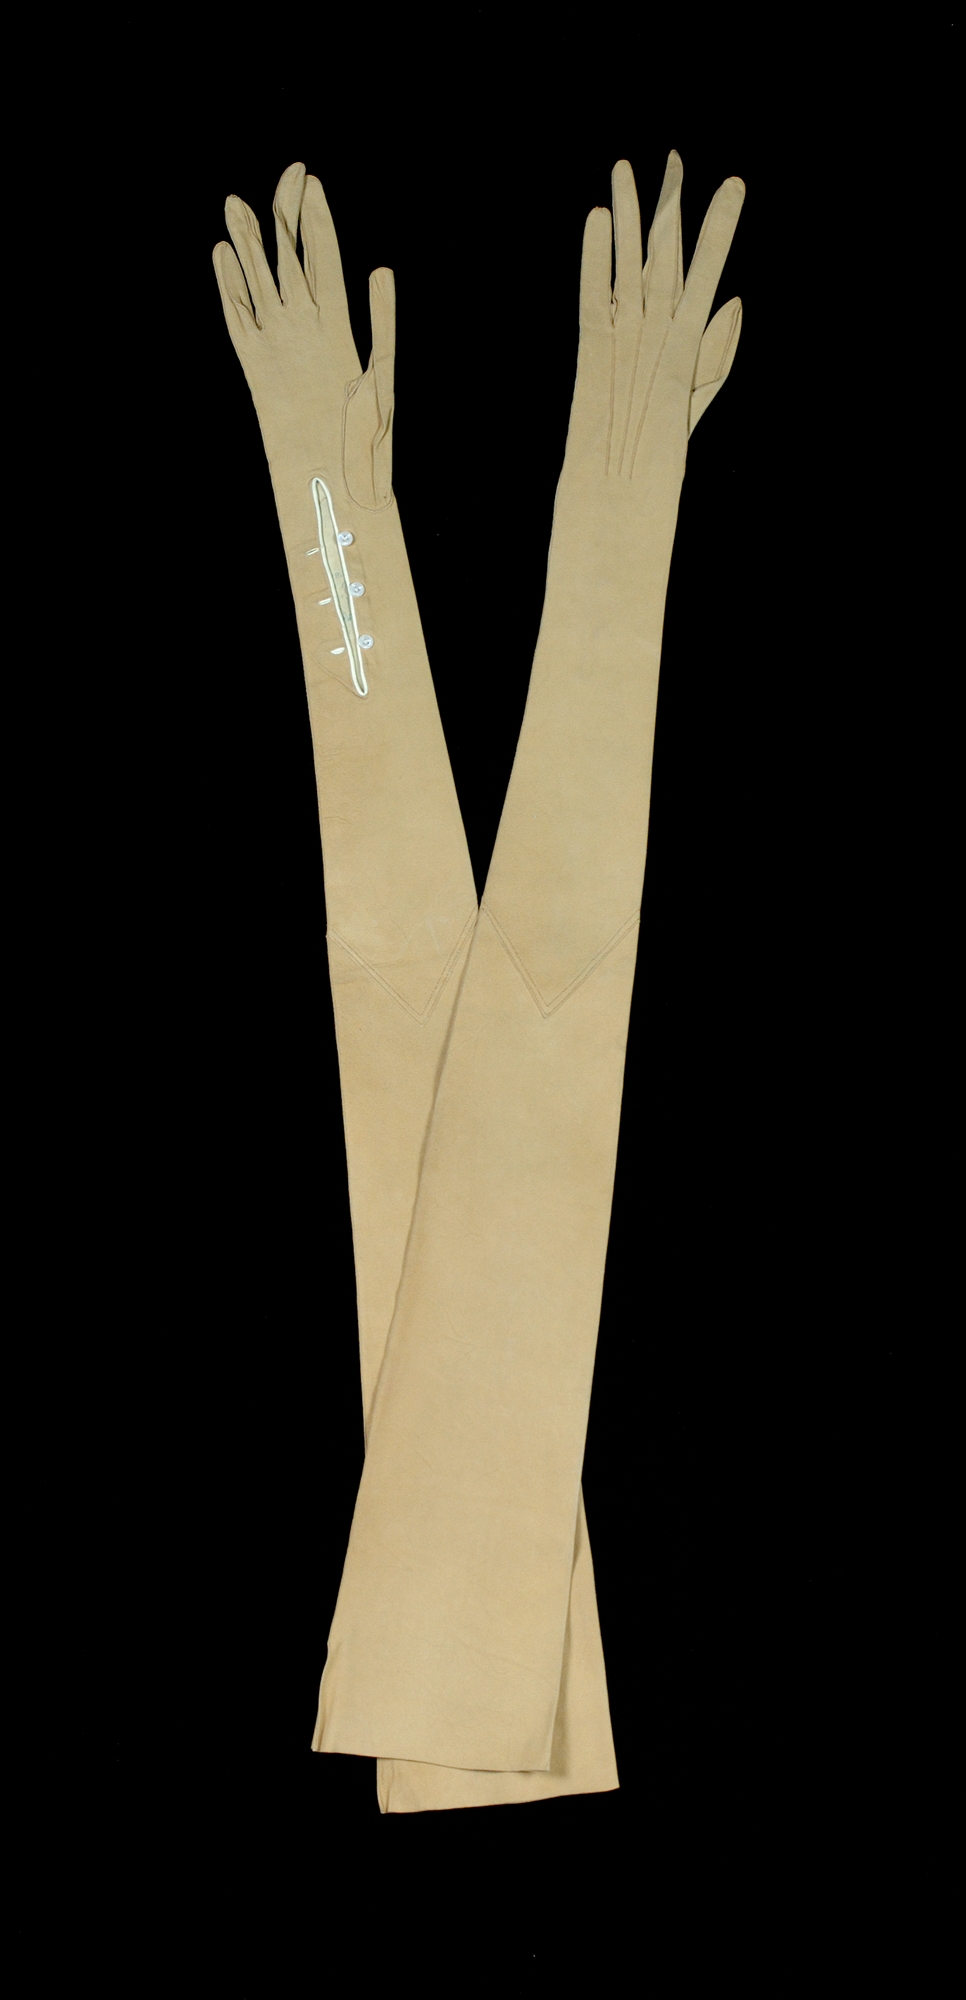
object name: evening glove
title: Evening gloves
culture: french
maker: bon marché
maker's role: department store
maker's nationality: french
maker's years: 1852-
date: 1885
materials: leather